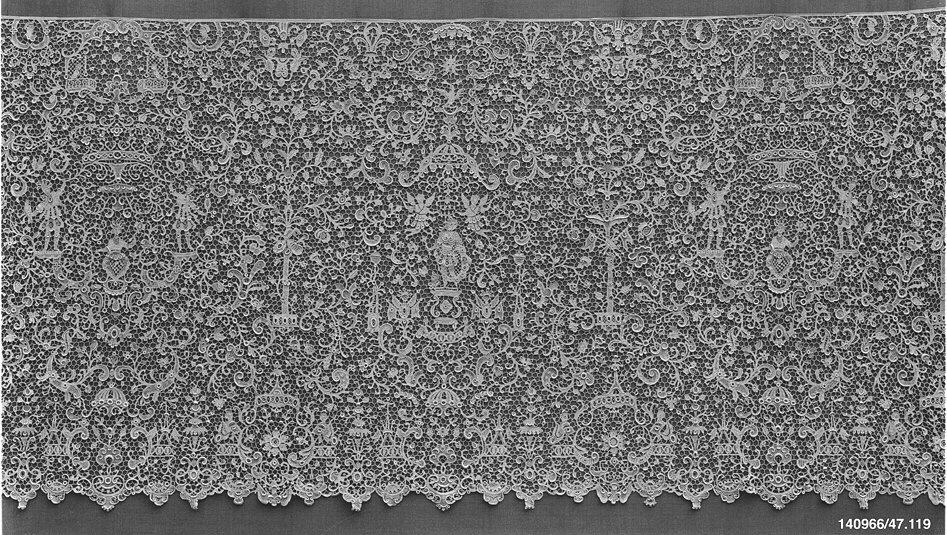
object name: flounce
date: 1867-1900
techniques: lace